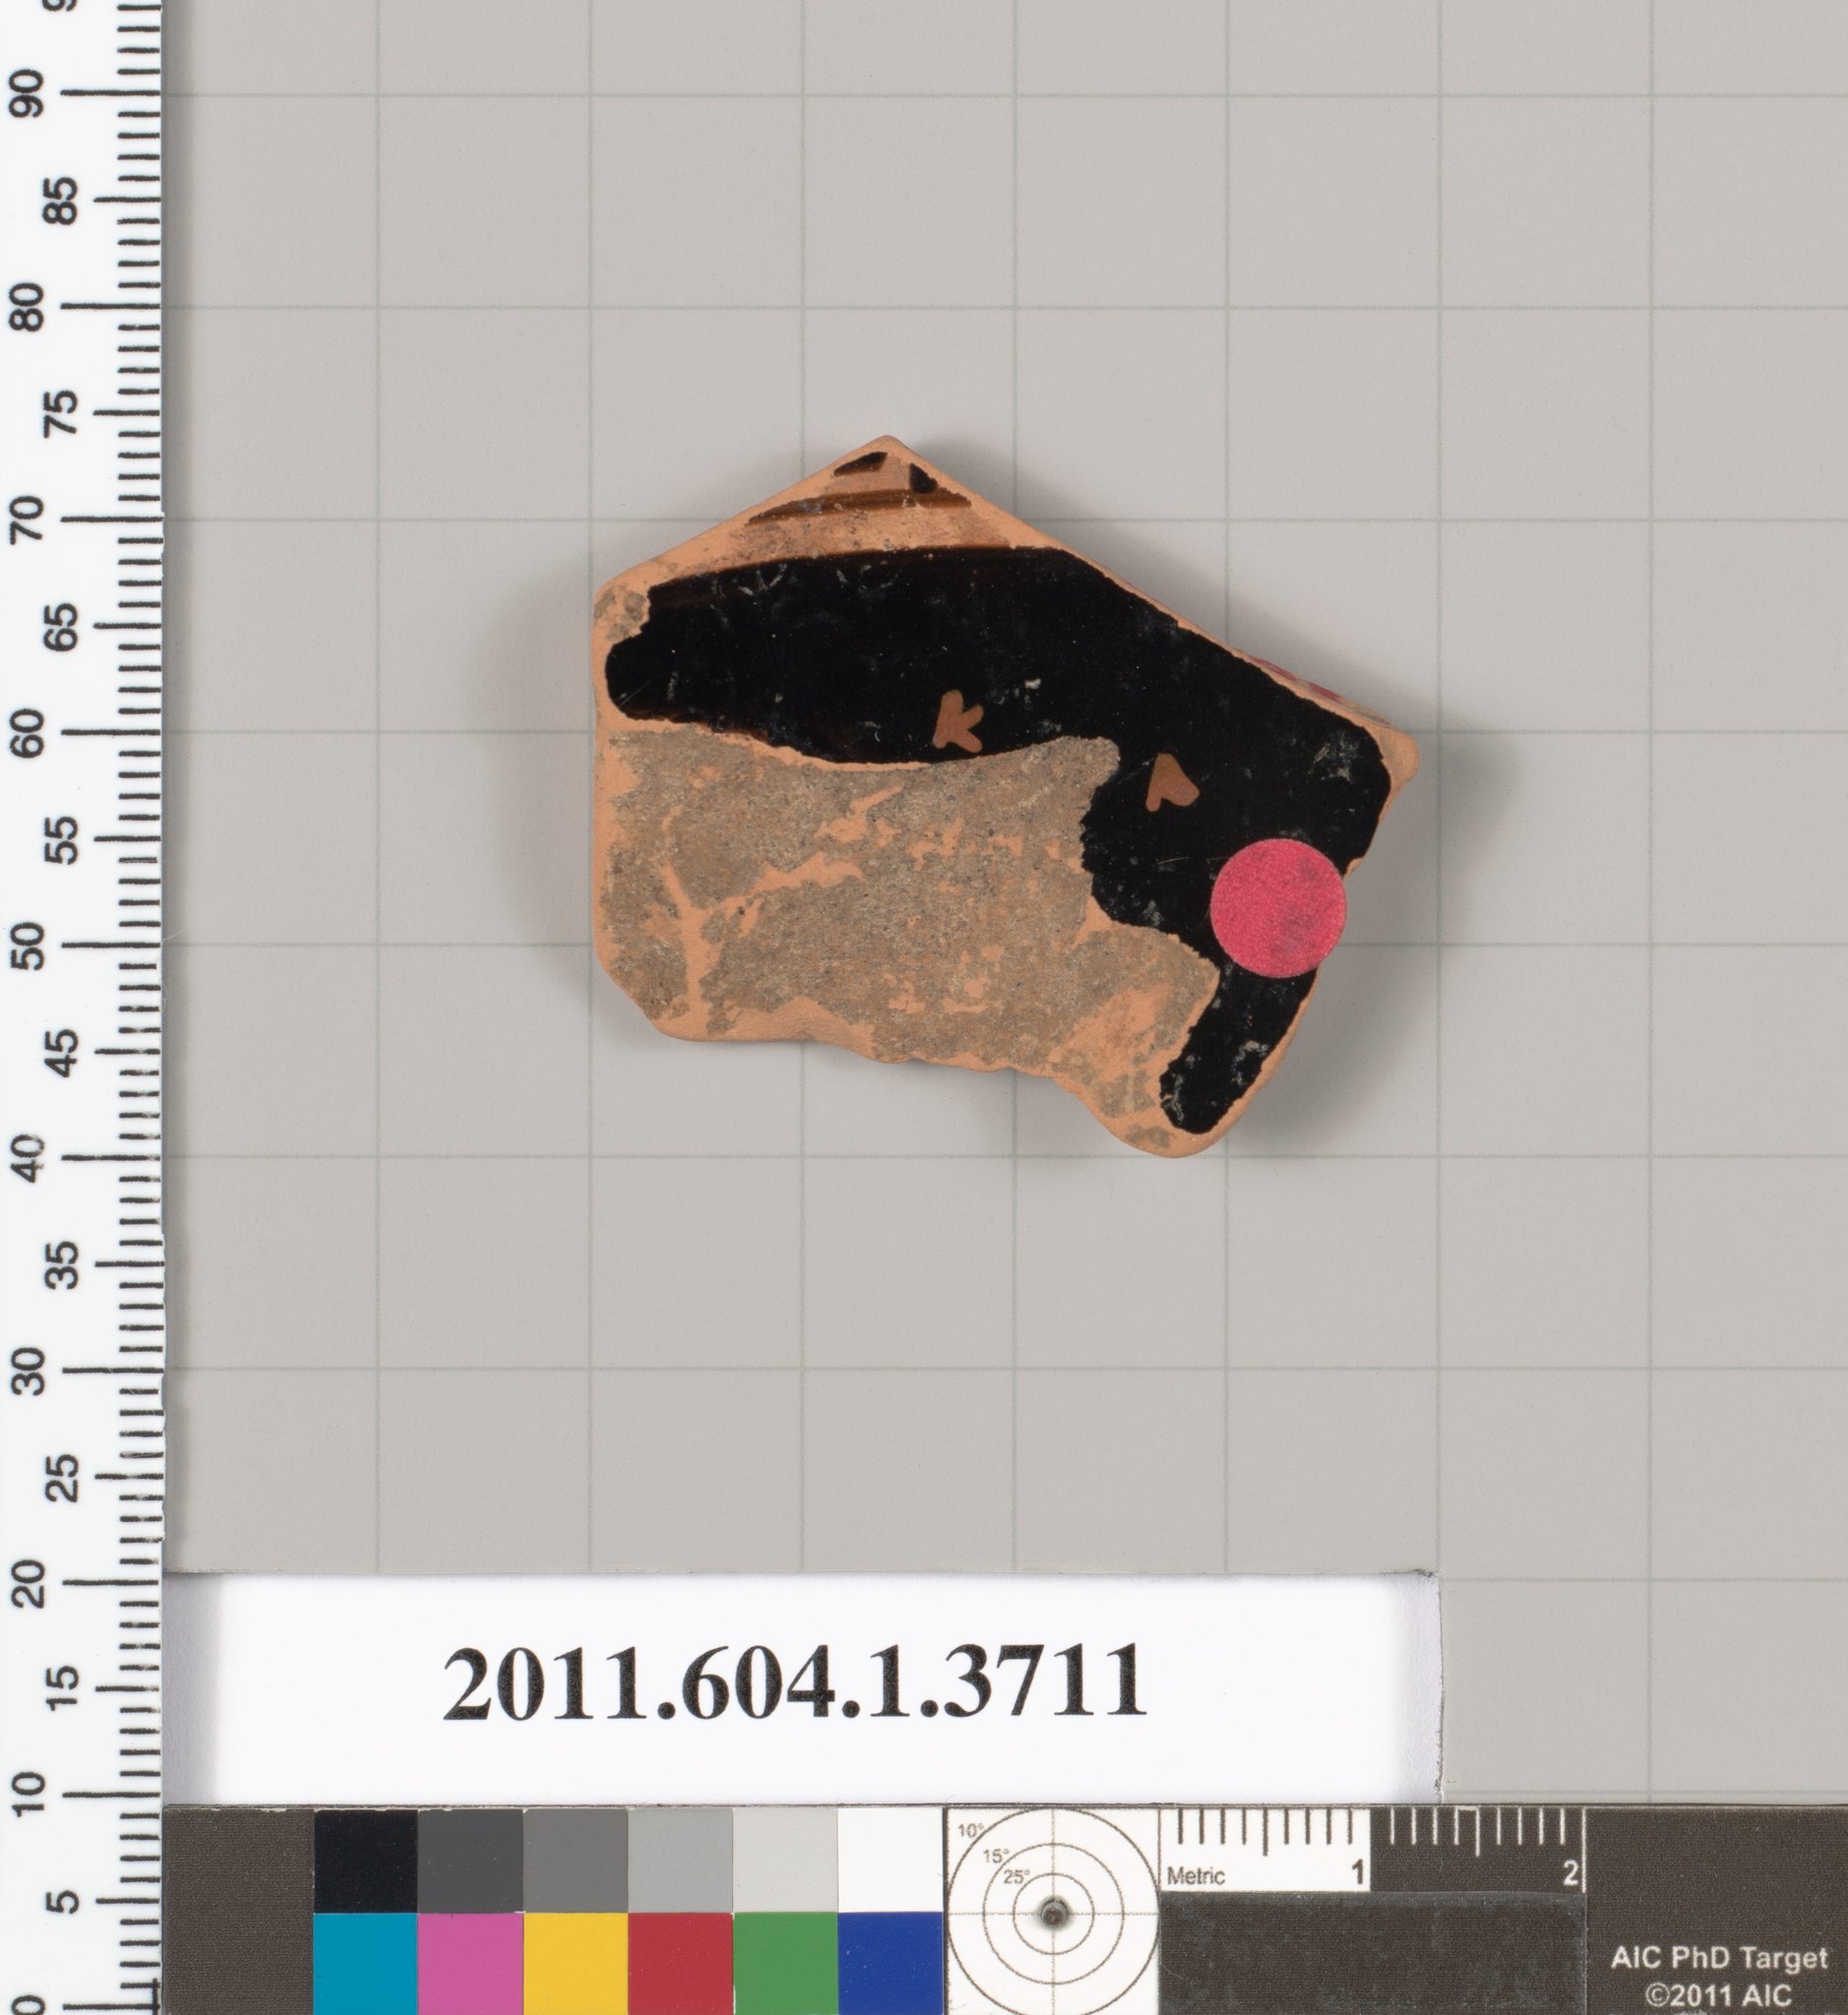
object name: kylix fragment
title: Terracotta fragment of a kylix (drinking cup)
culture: greek, attic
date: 490-470 BCE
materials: terracotta